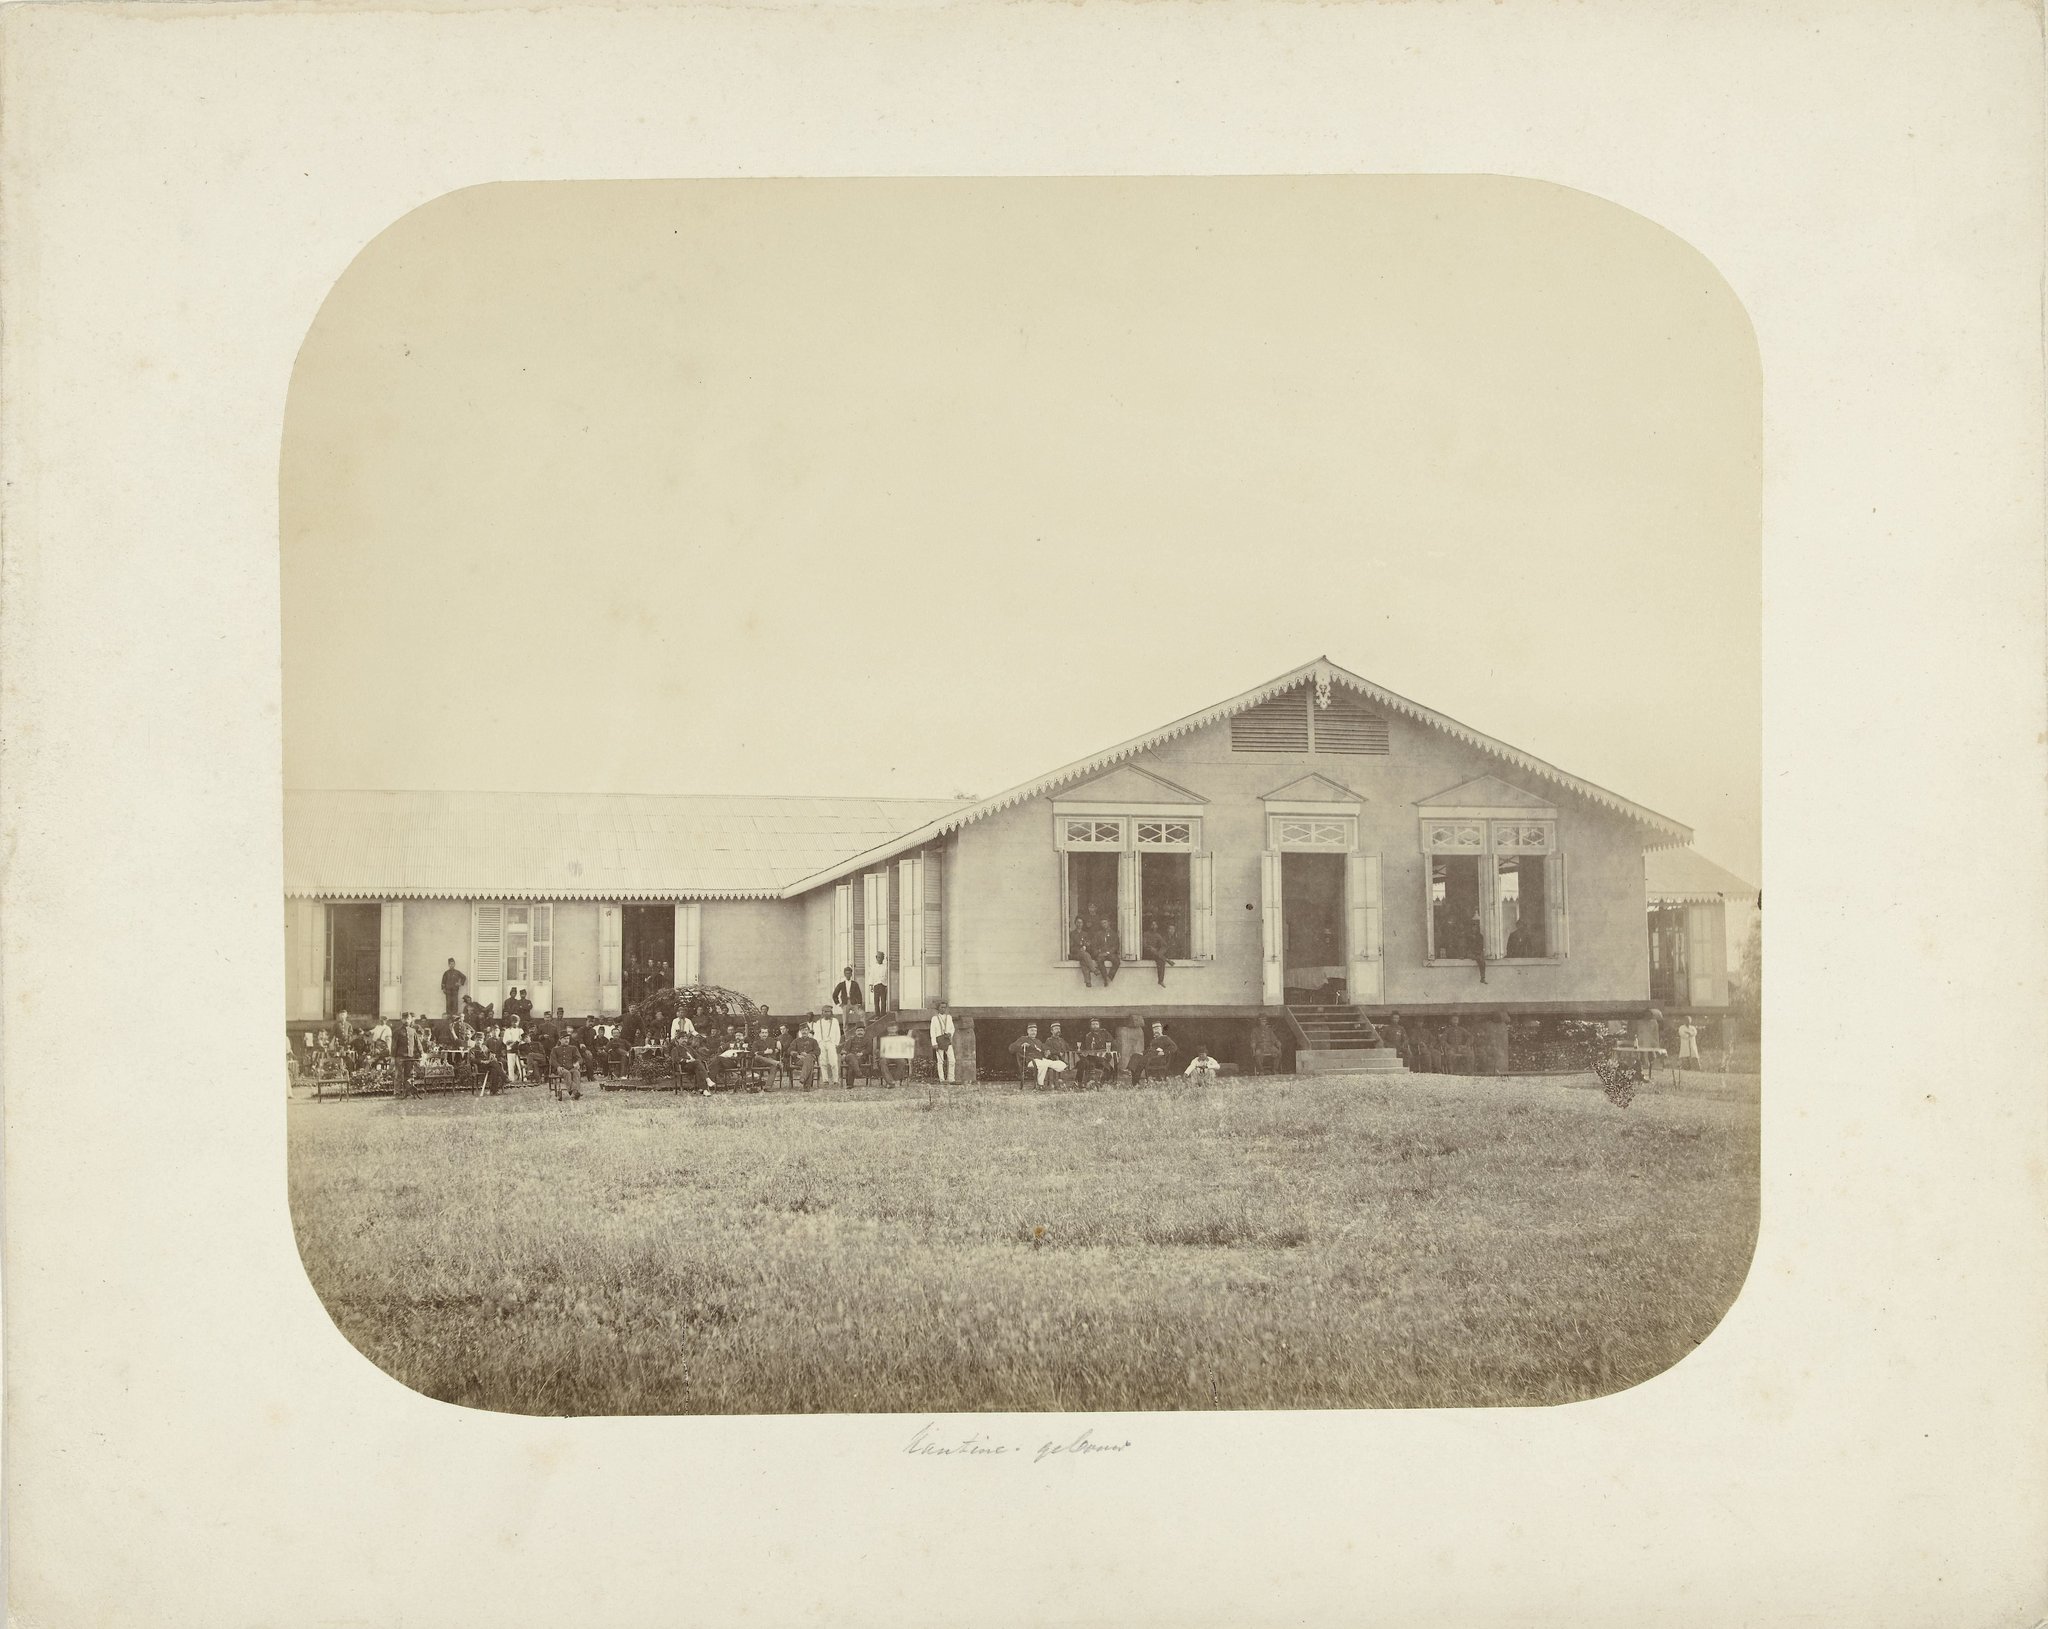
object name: photograph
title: Groep militairen bij een kantinegebouw, Nederlands-Indië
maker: Anonymous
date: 1870-1900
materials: cardboard, paper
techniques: albumen print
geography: dutch east indies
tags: mess ~ the soldier off duty, barracks, dutch east indies, the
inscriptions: inscription: ‘Kantine-gebouw’